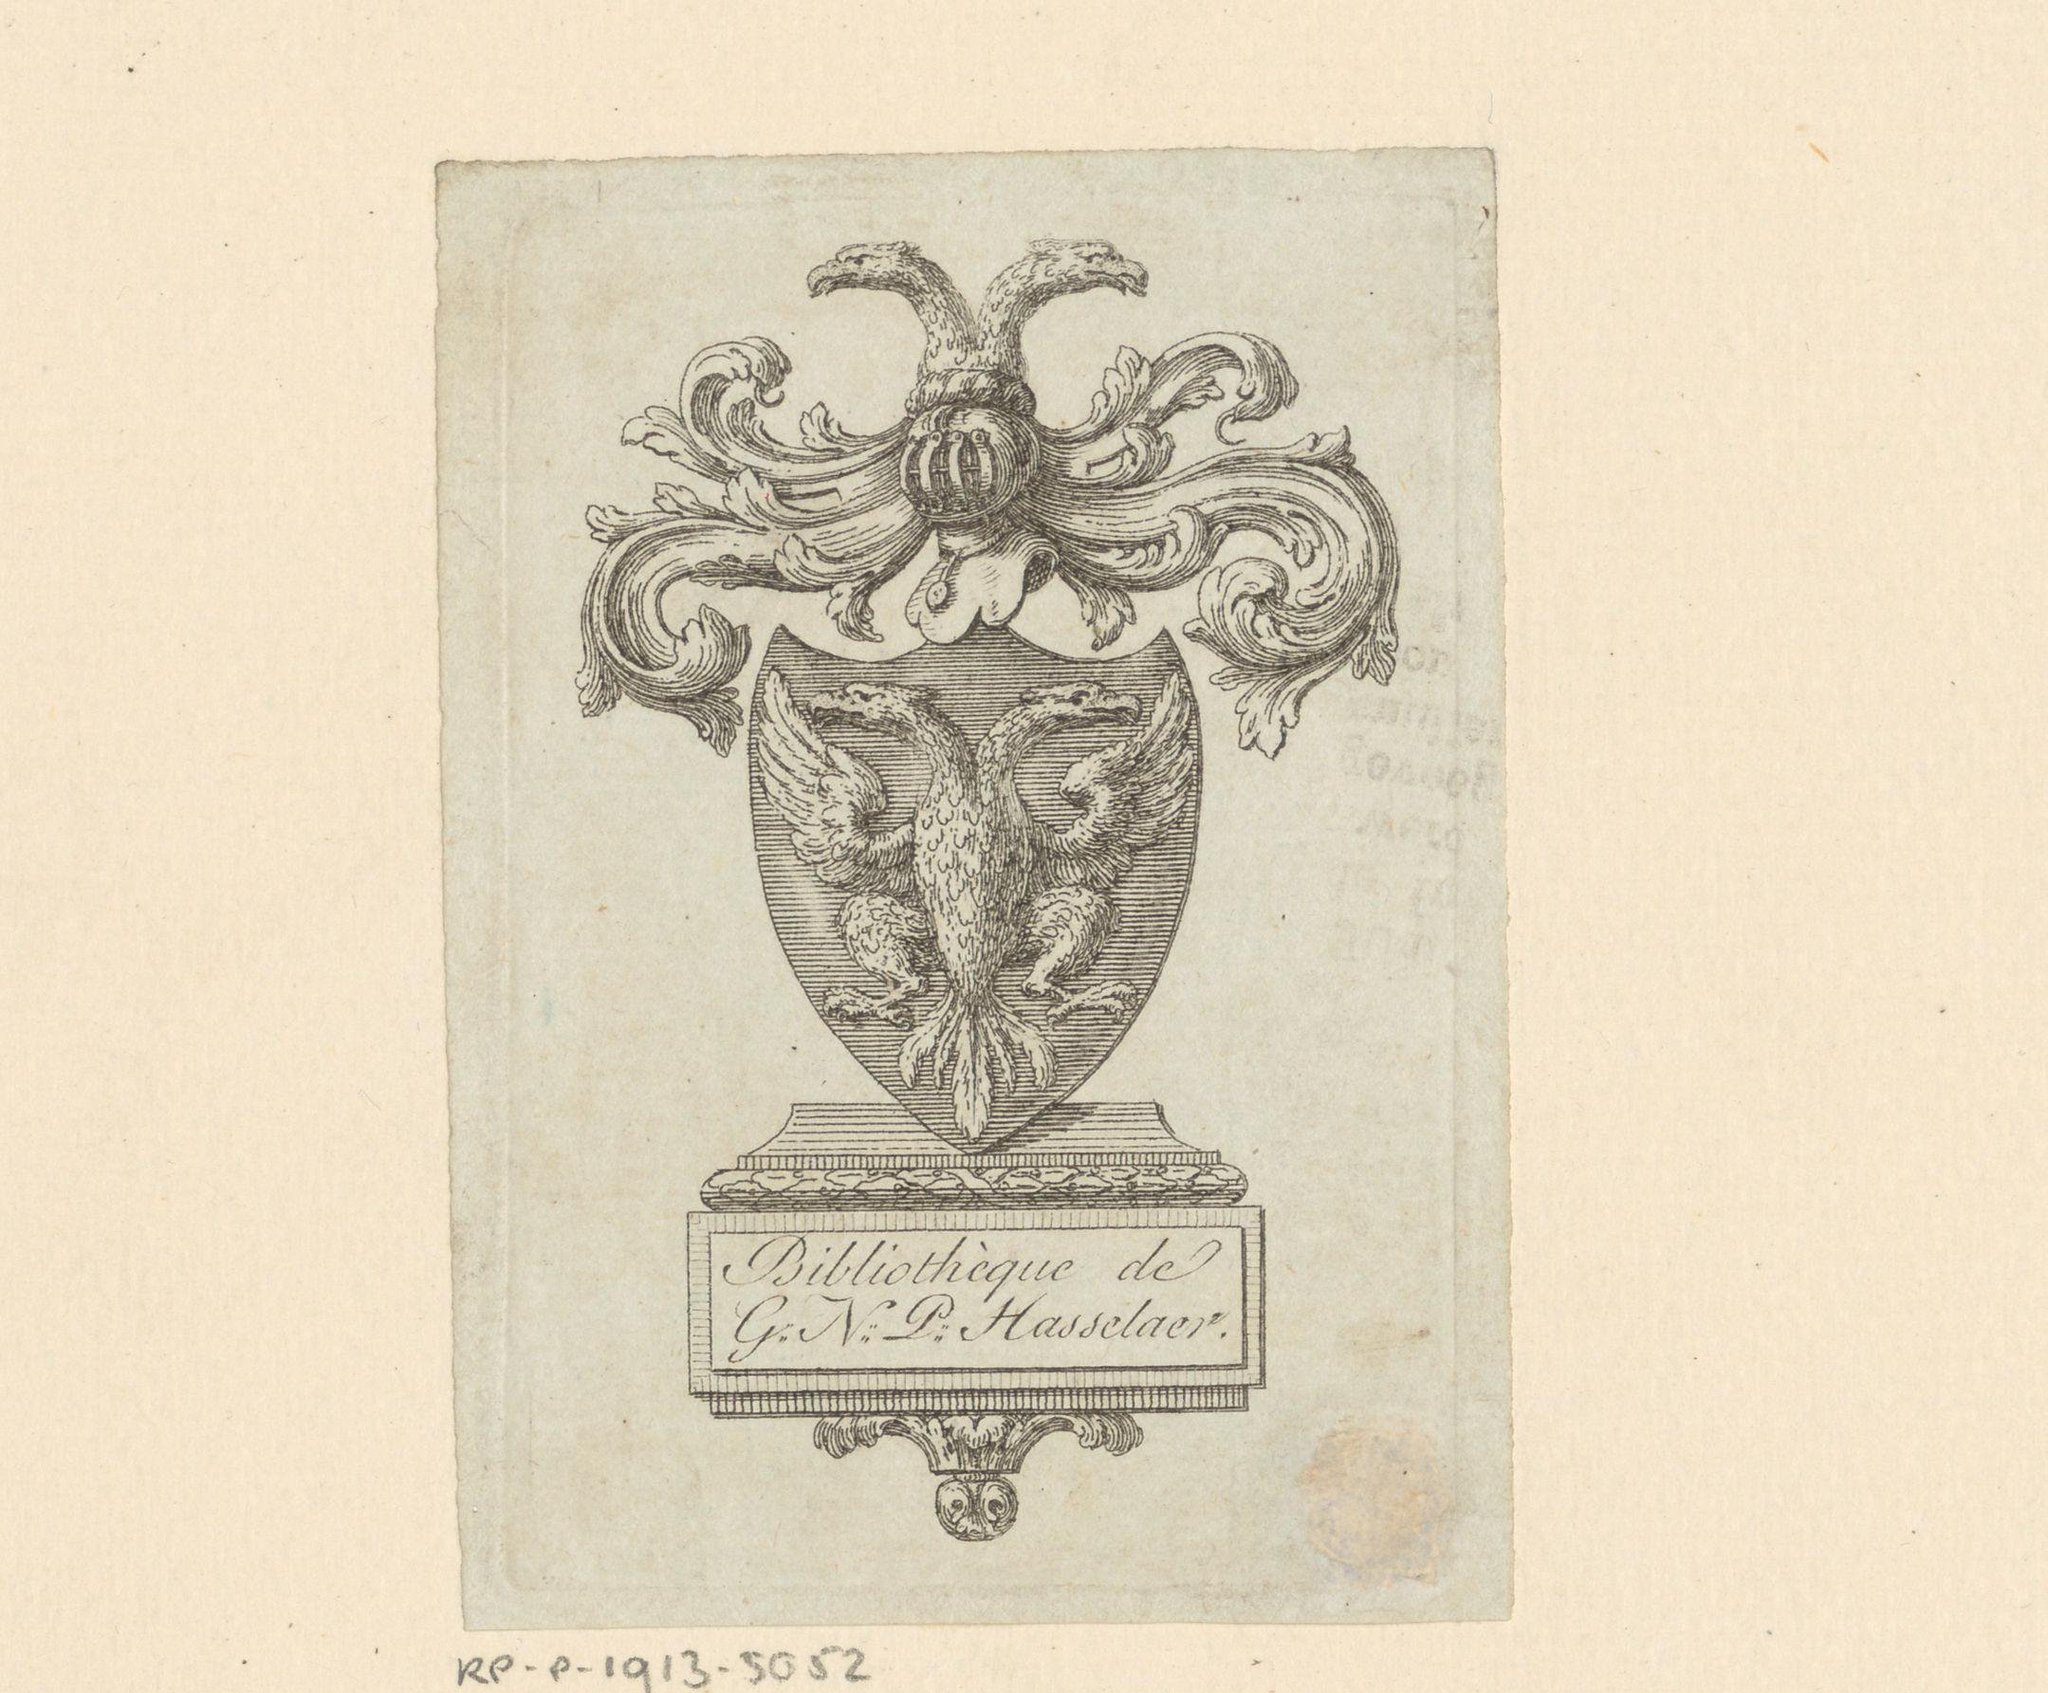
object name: bookplate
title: Ex libris van G.N.P Hasselaer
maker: Anonymous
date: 1750-1849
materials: paper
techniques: etching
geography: netherlands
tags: double-headed eagle, armorial bearing, heraldry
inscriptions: collector's mark: Lugt 2760, collector's mark: Lugt 2233